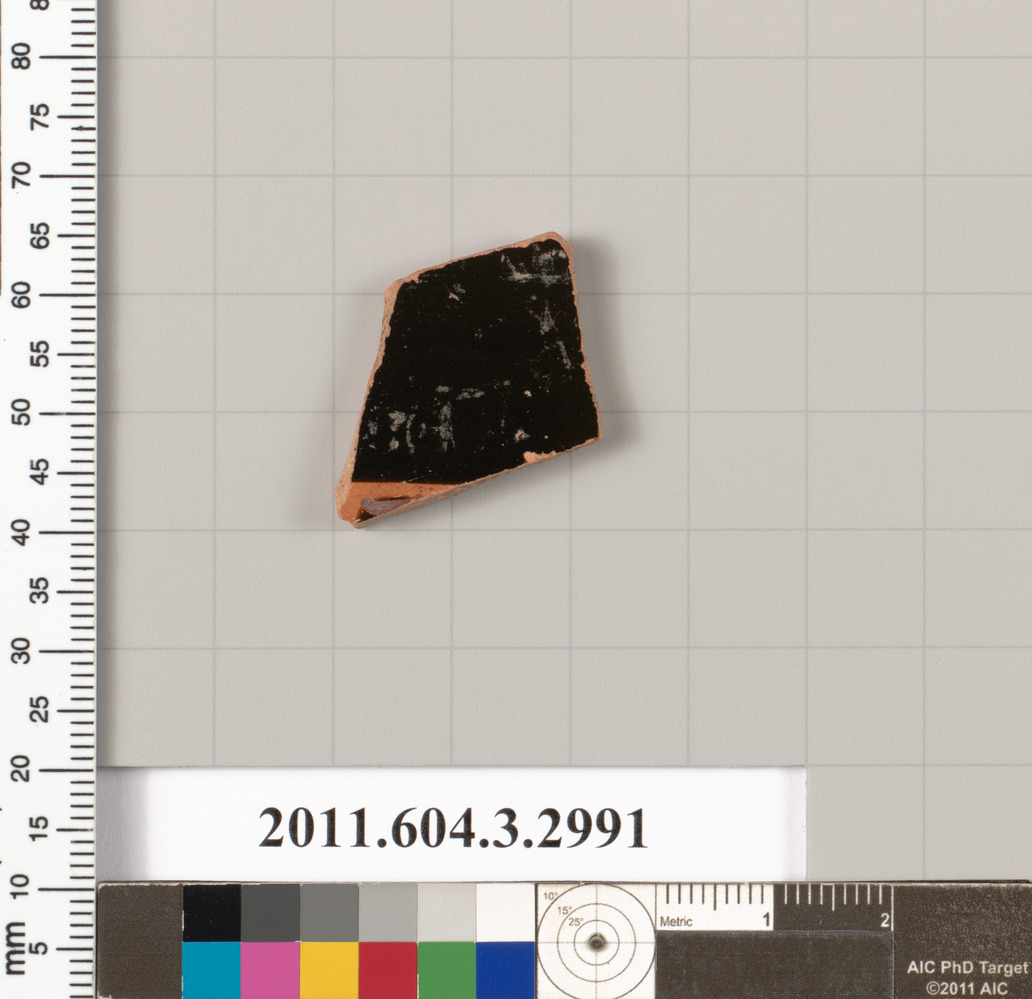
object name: undetermined shape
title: Terracotta fragment of an undetermined shape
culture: greek, attic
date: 534-468 BCE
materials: terracotta